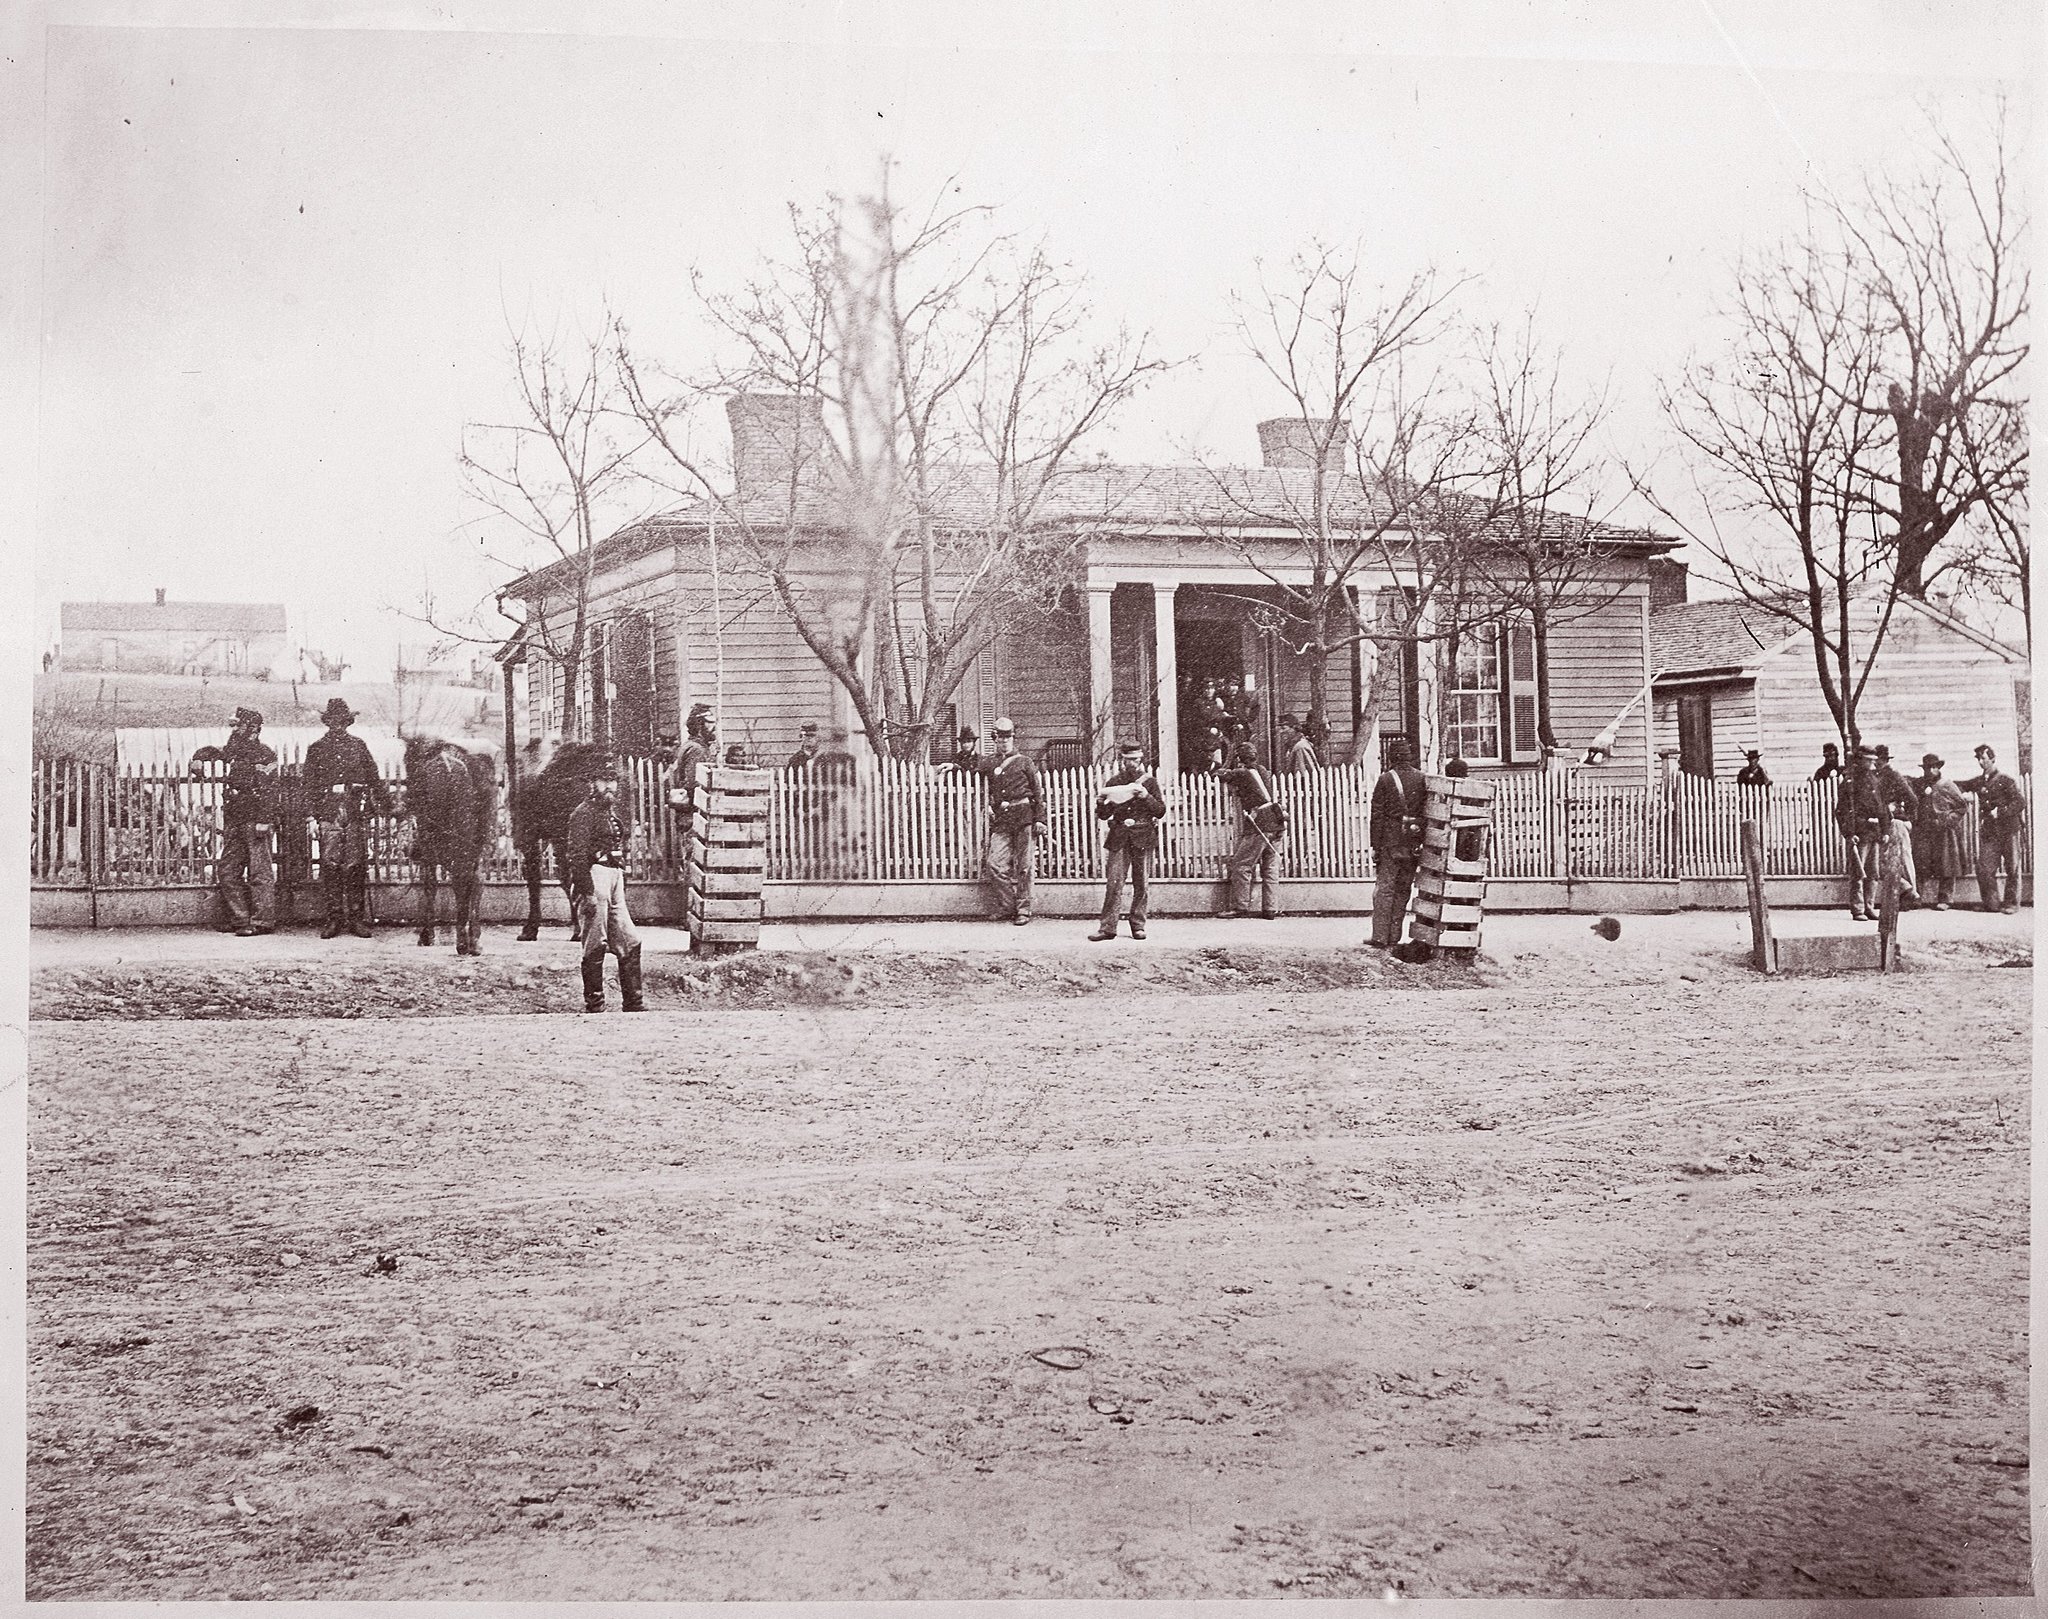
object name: photograph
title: Headquarters of General Sherman or Thomas, Chattanooga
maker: george n. barnard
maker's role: artist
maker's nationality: american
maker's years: 1819-1902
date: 1864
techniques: albumen silver print, glass negative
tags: buildings,soldiers,american civil war